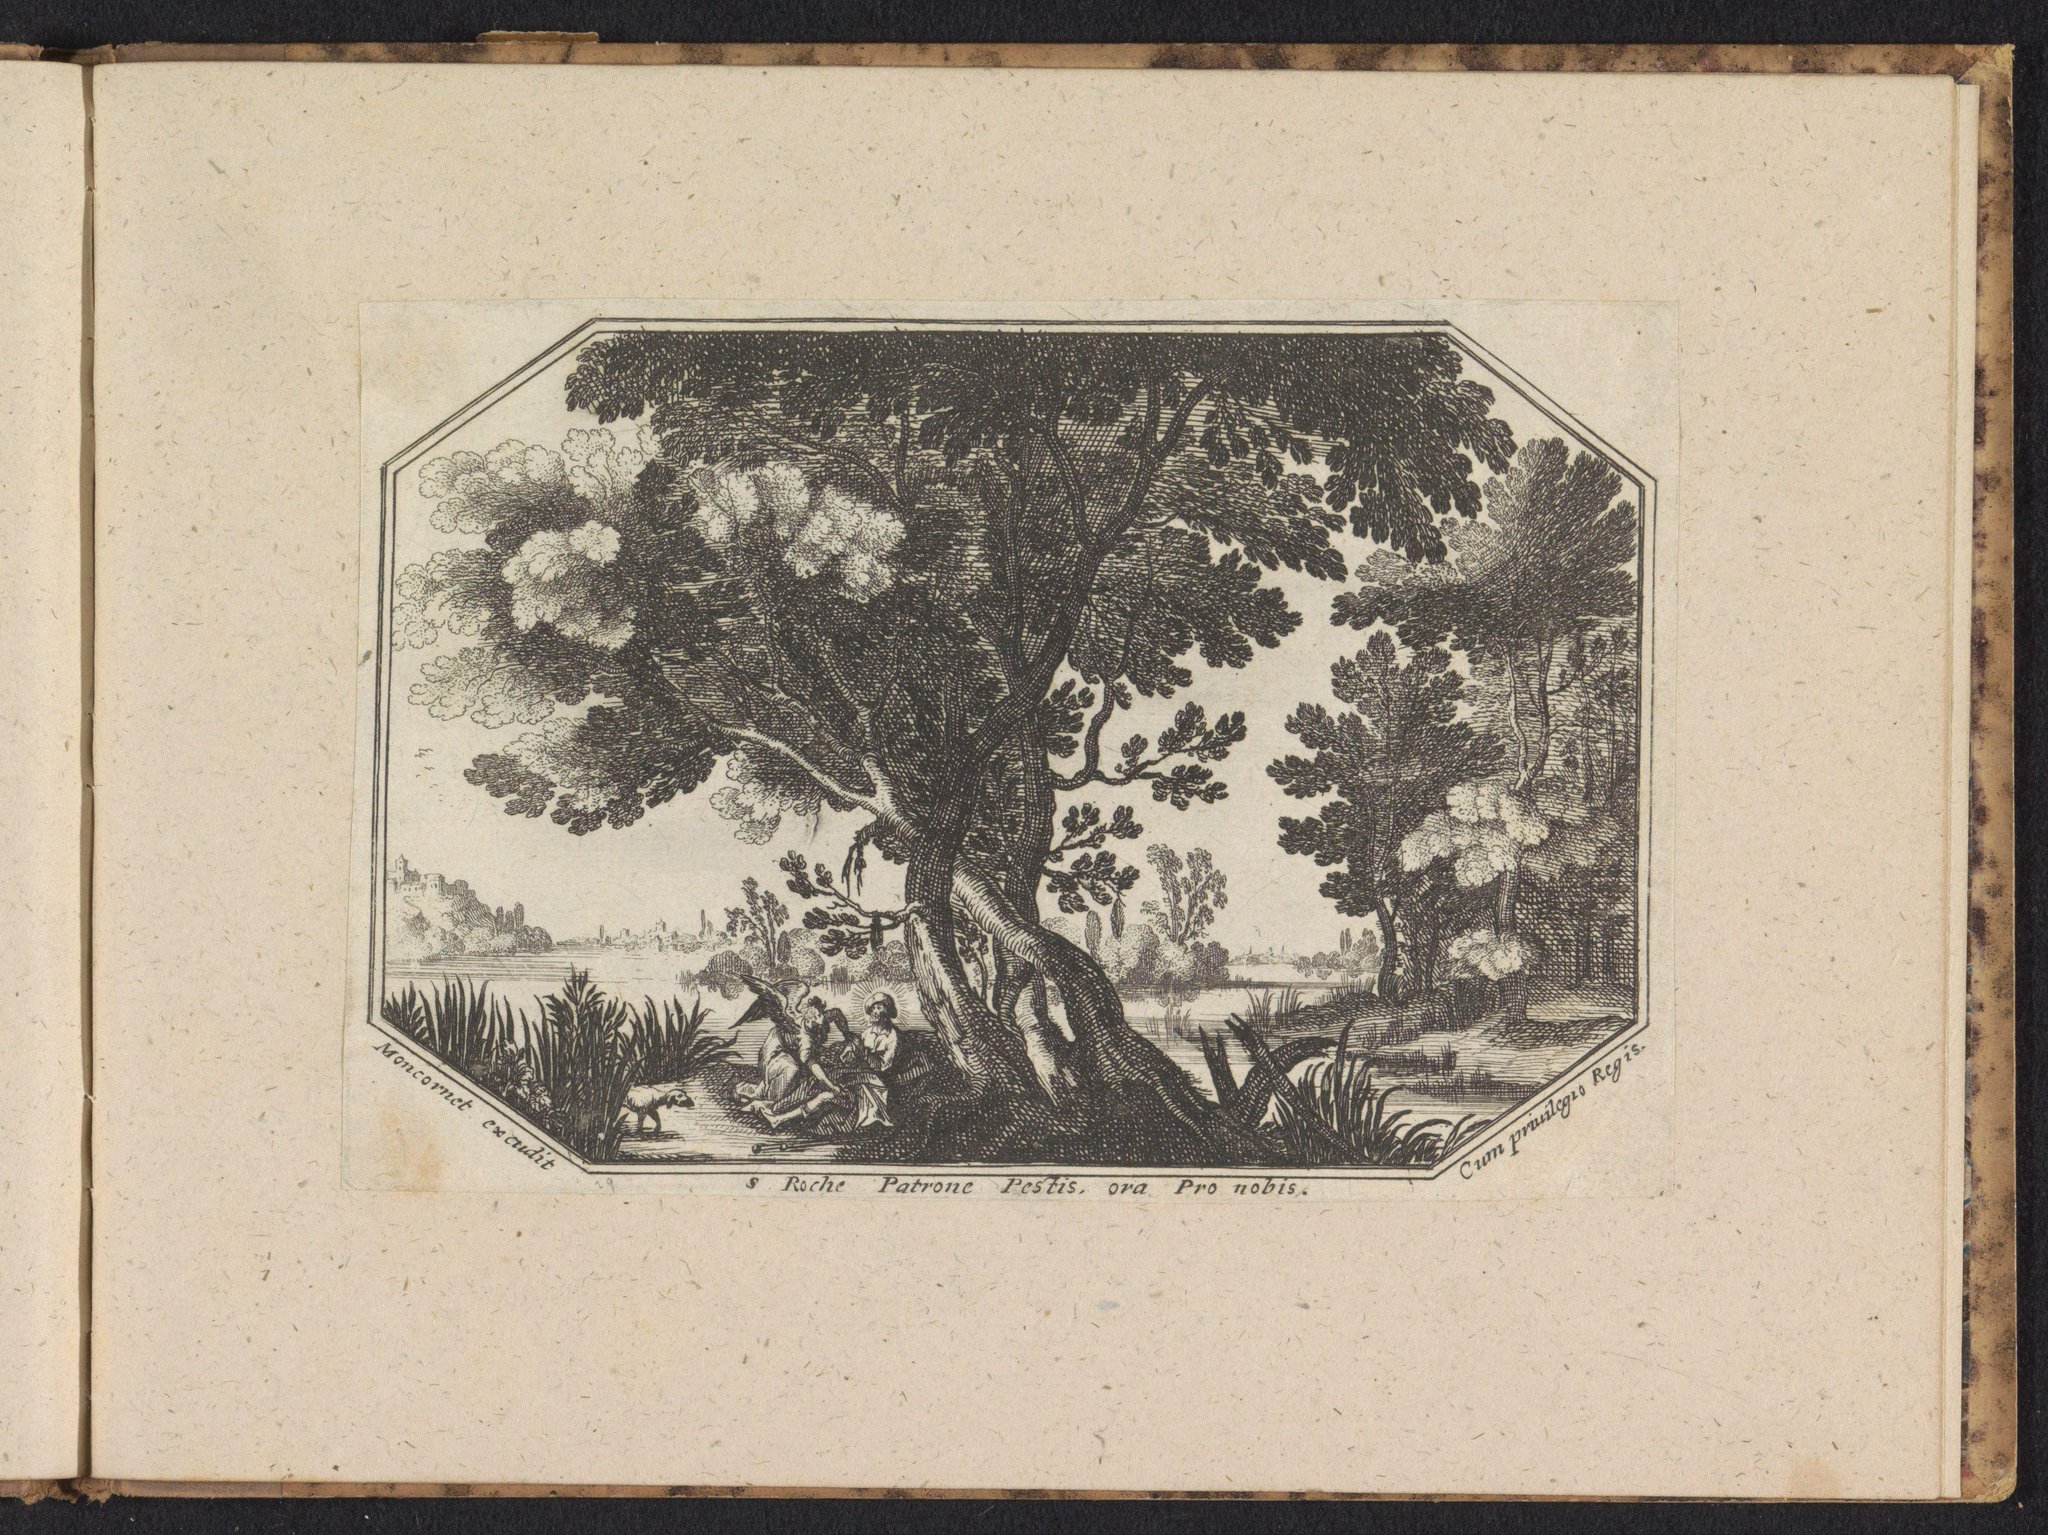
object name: print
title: Landschap met S. Rochus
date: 1600-1699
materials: paper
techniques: etching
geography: france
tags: the confessor and pilgrim roch(us) (rocco, rock) of montpellier; possible attributes: angel (with ointment box or spoon), dog (sometimes with loaf), (pointing at) plague-spot on thigh, pilgrim's shell, staff, hat and wallet, landscapes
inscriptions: collector's mark: Lugt 2228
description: Achthoekig boomrijk landschap. Bij de boom in het midden zit de heilige Rochus. Een engel kijkt naar de pestbuilen op zijn been. Daarnaast een hond. De prent maakt deel uit van een album.